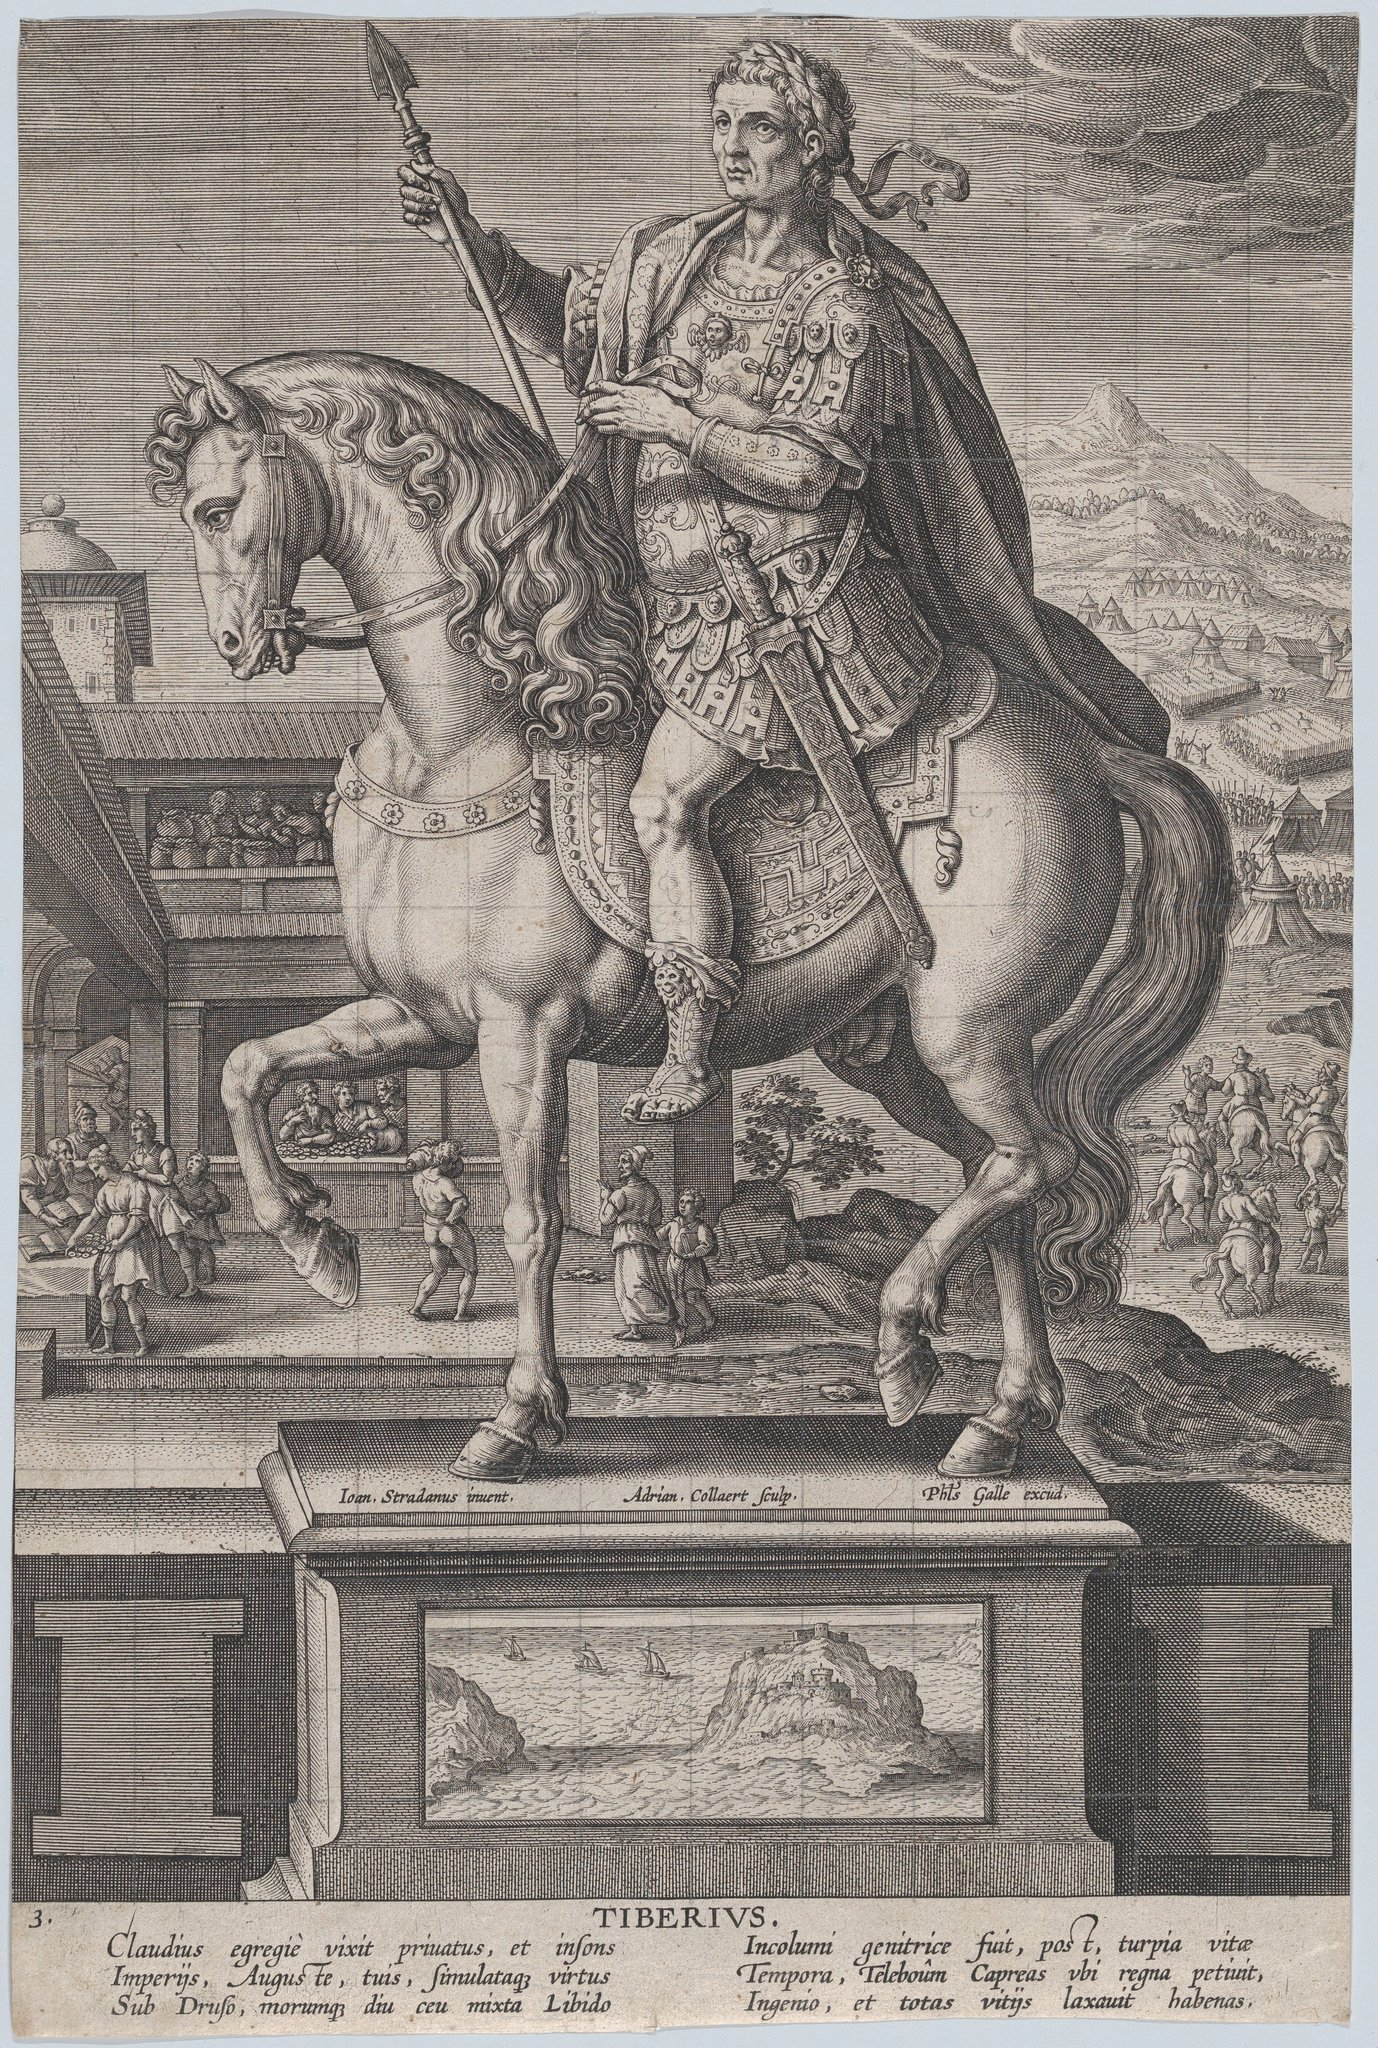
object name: print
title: Plate 3: equestrian statue of Tiberius, in profile to the left, with a naval landscape on pedestal below, from 'Roman Emperors on Horseback'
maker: adriaen collaert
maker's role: artist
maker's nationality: netherlandish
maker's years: 1560-1618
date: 1587-1589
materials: graphite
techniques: engraving, drawing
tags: weapons,men,horses,landscapes